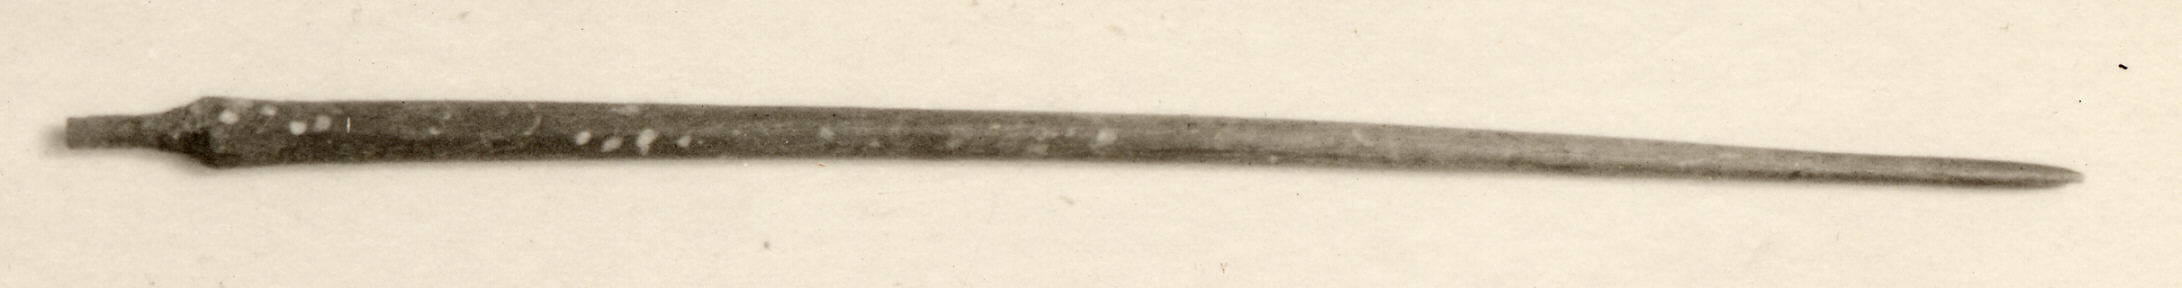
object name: hair pin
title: Hairpin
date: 2030-1640 BCE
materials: wood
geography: egypt